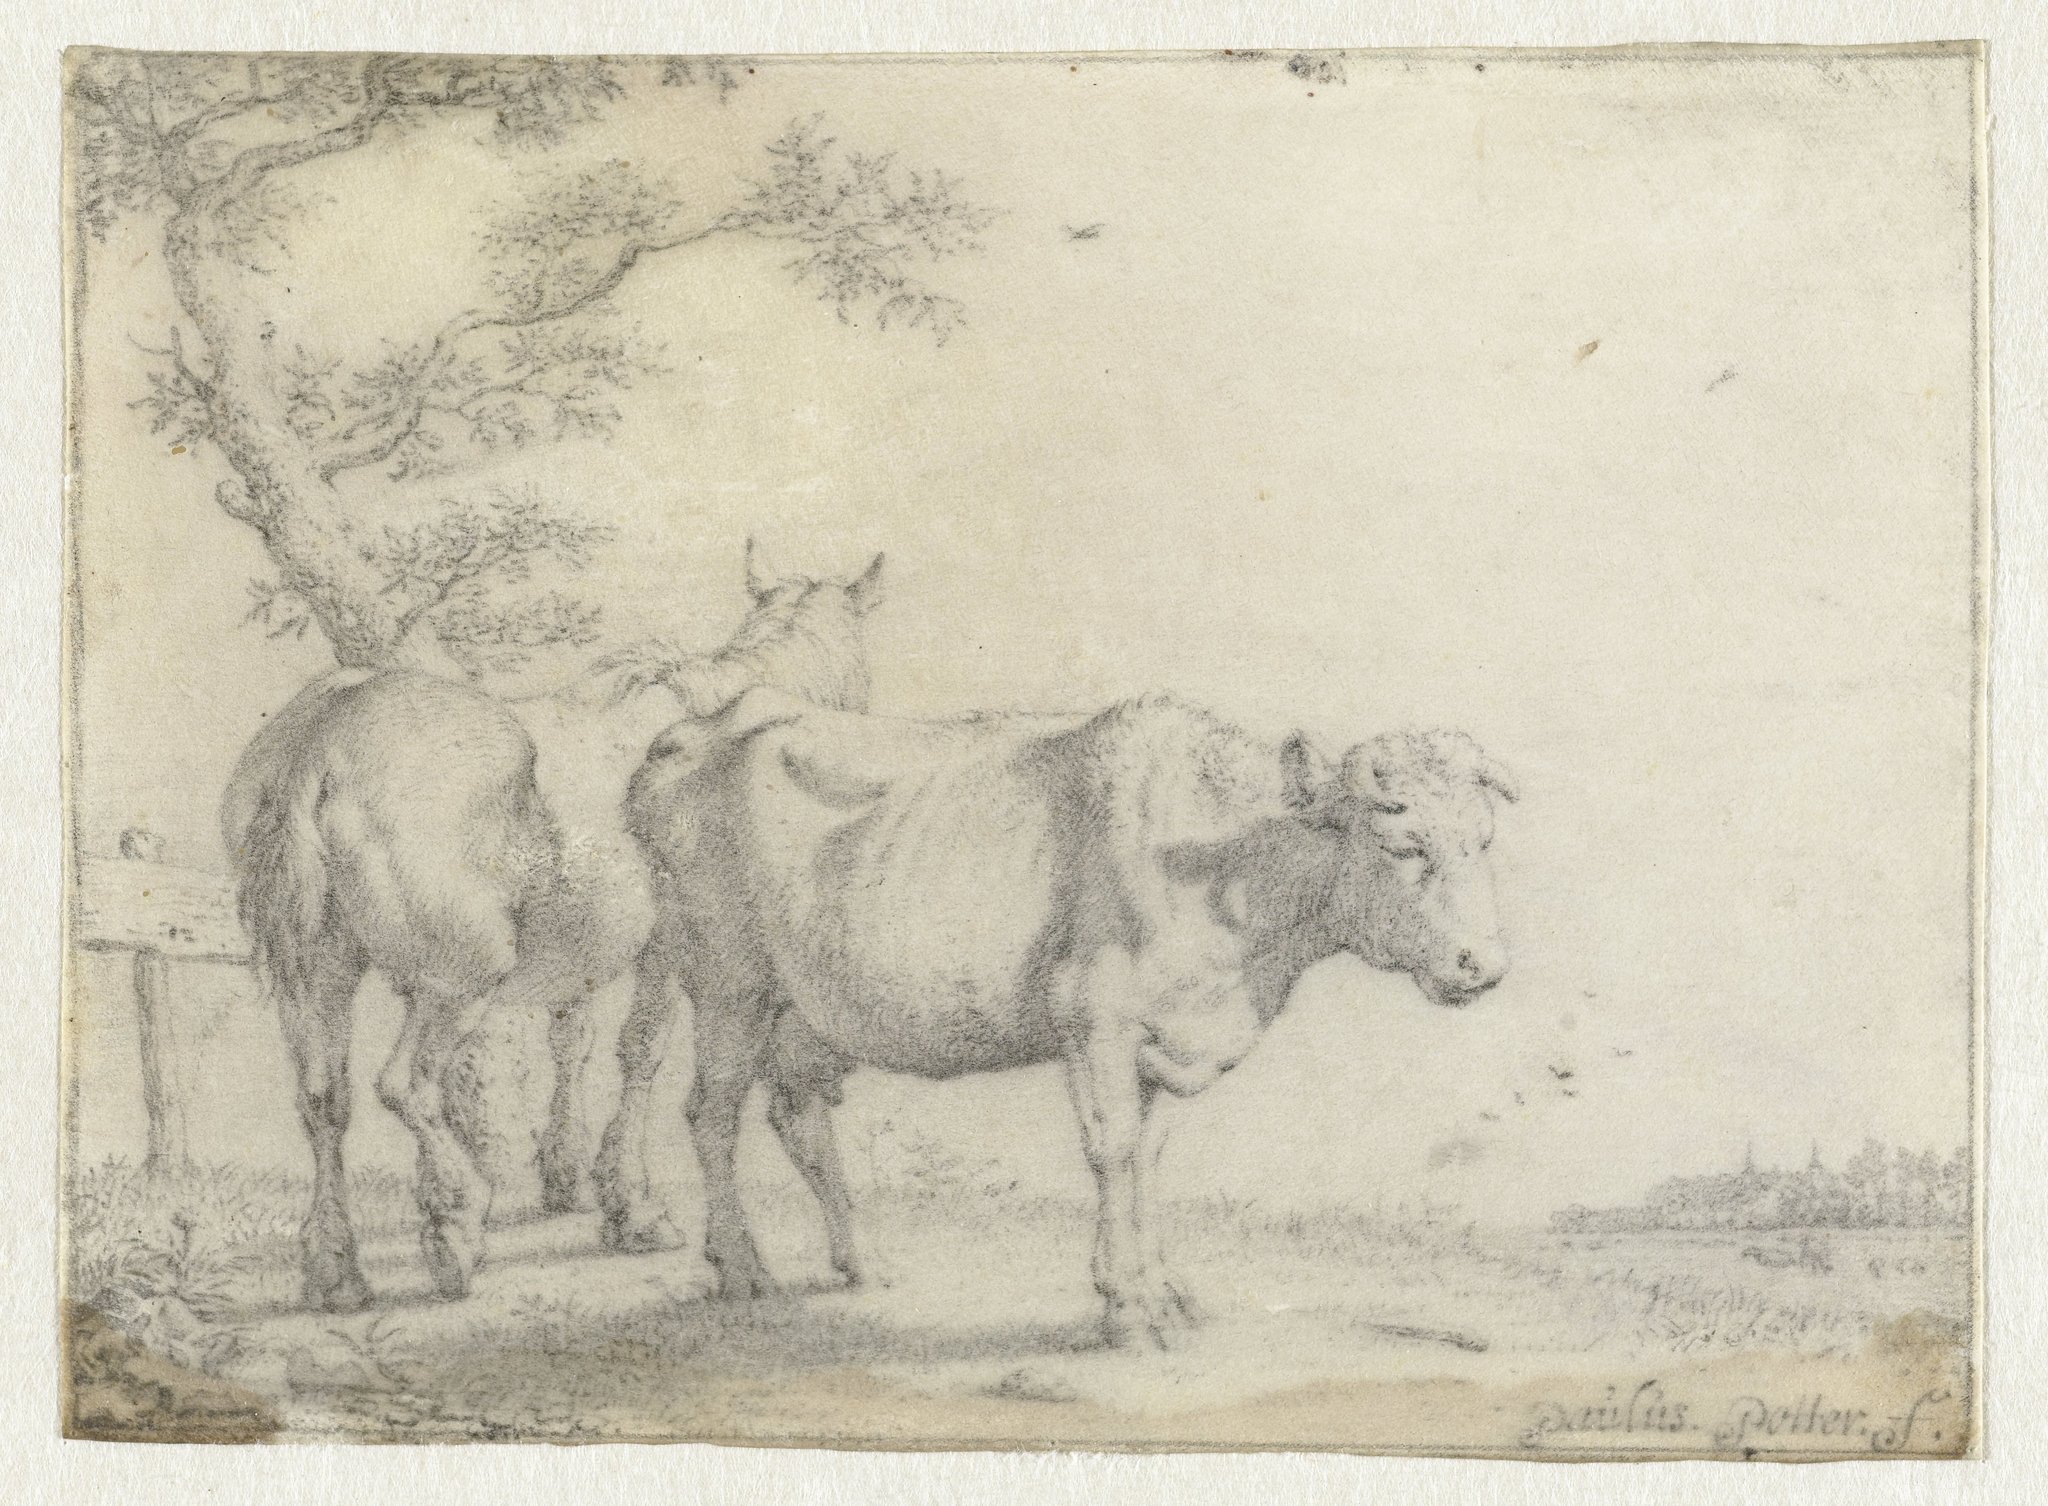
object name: drawing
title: Paard en een koe bij een boom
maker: paulus potter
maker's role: draughtsman, painter, print maker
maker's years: 1625-1654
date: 1635-1654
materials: parchment, pencil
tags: cow, horse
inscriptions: : Lugt 240